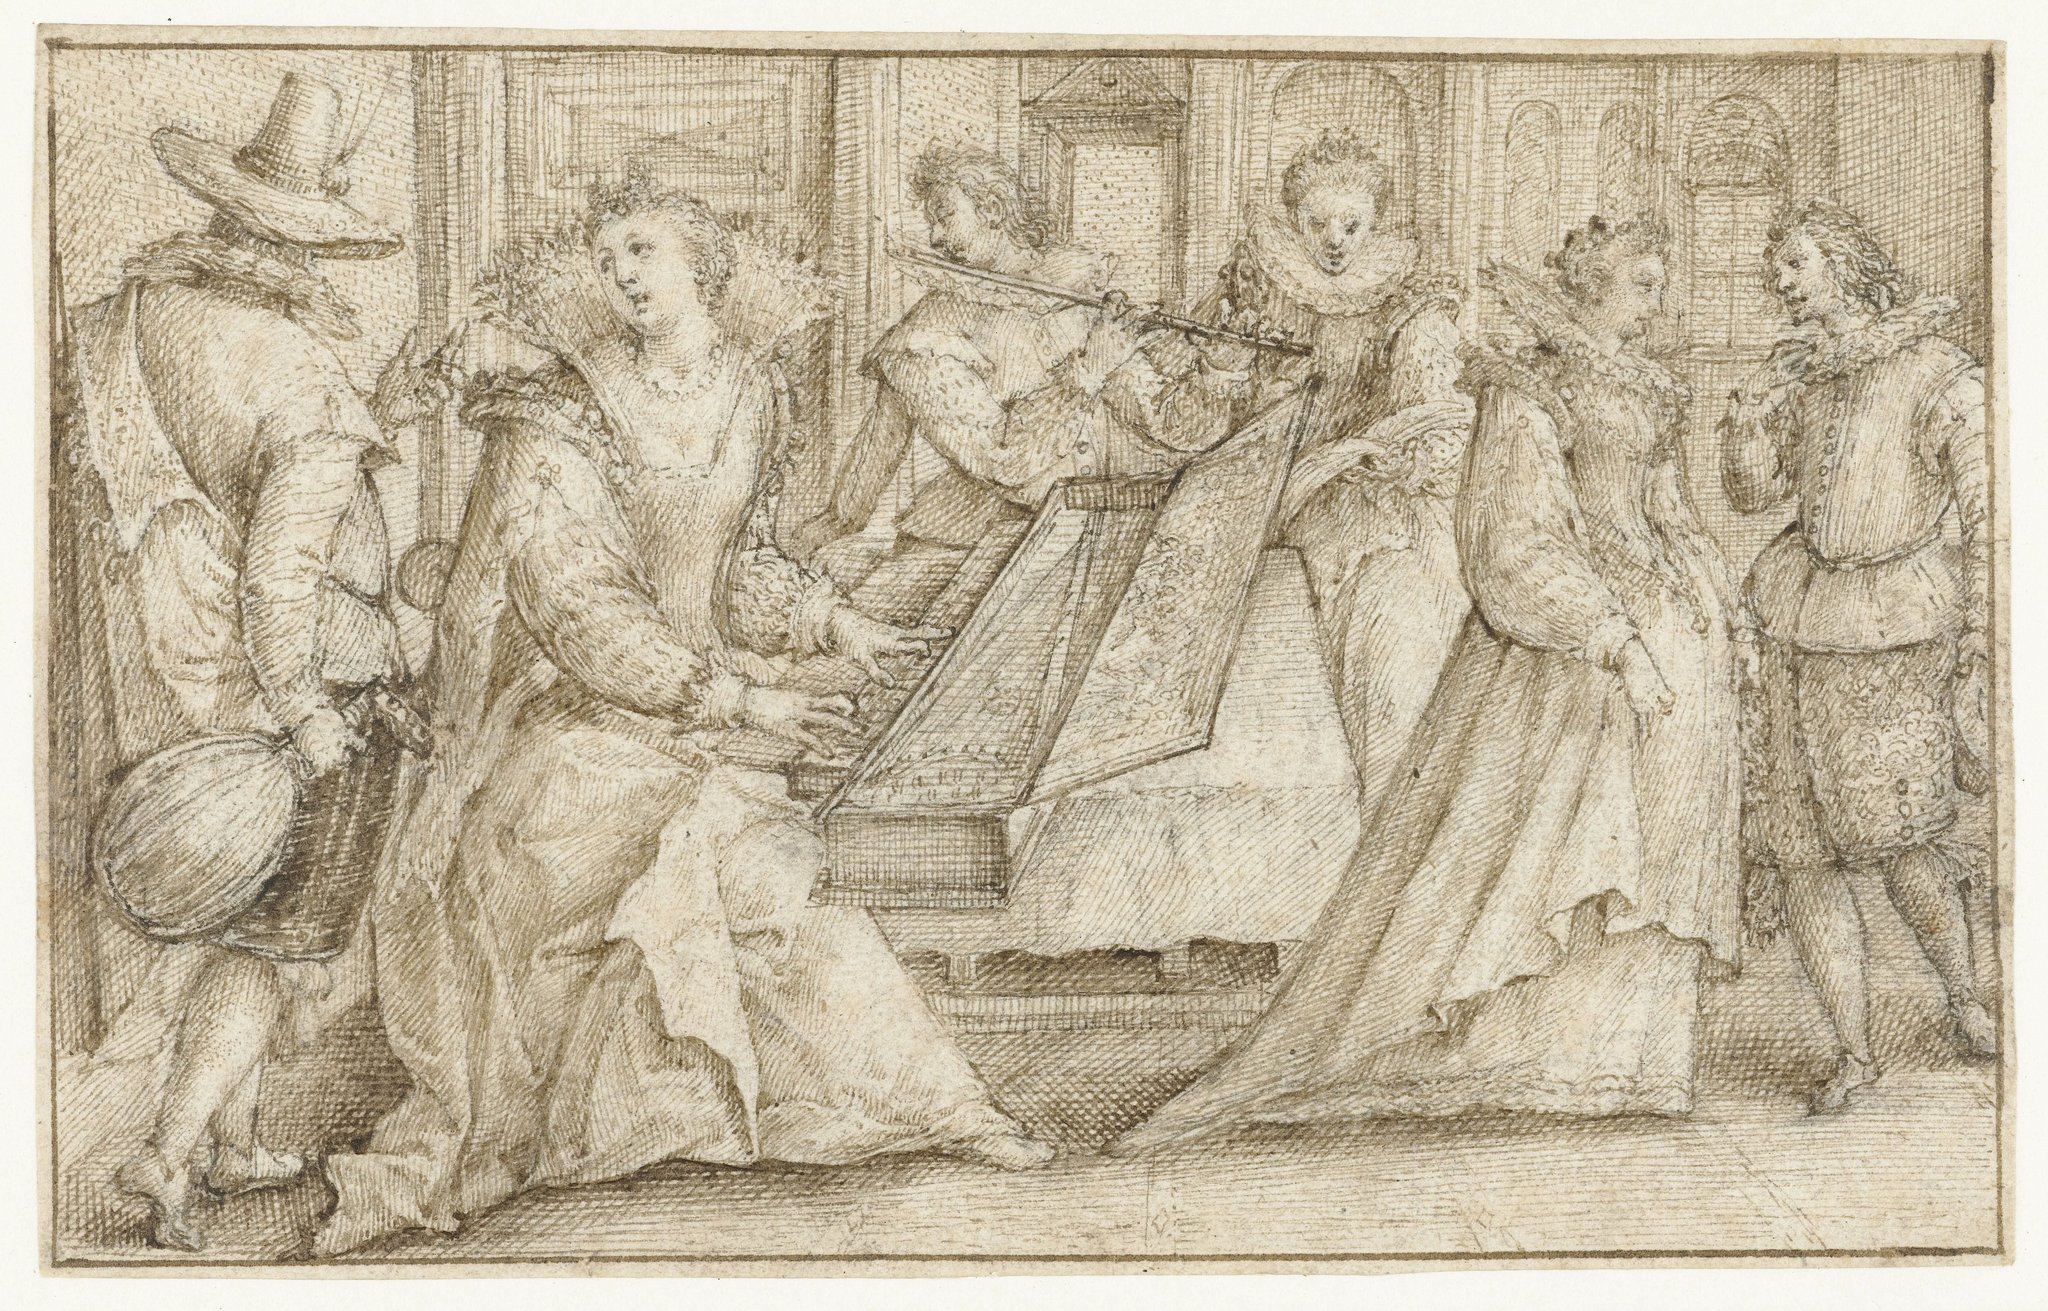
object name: design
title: Hortus Voluptatum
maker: crispijn van de passe (i)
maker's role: draughtsman, print maker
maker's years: 1564-1637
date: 1575-1599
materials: chalk, ink, paper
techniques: pen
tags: instrumental and vocal music together, ball, formal dance, one pair dancing; man and woman dancing as a couple